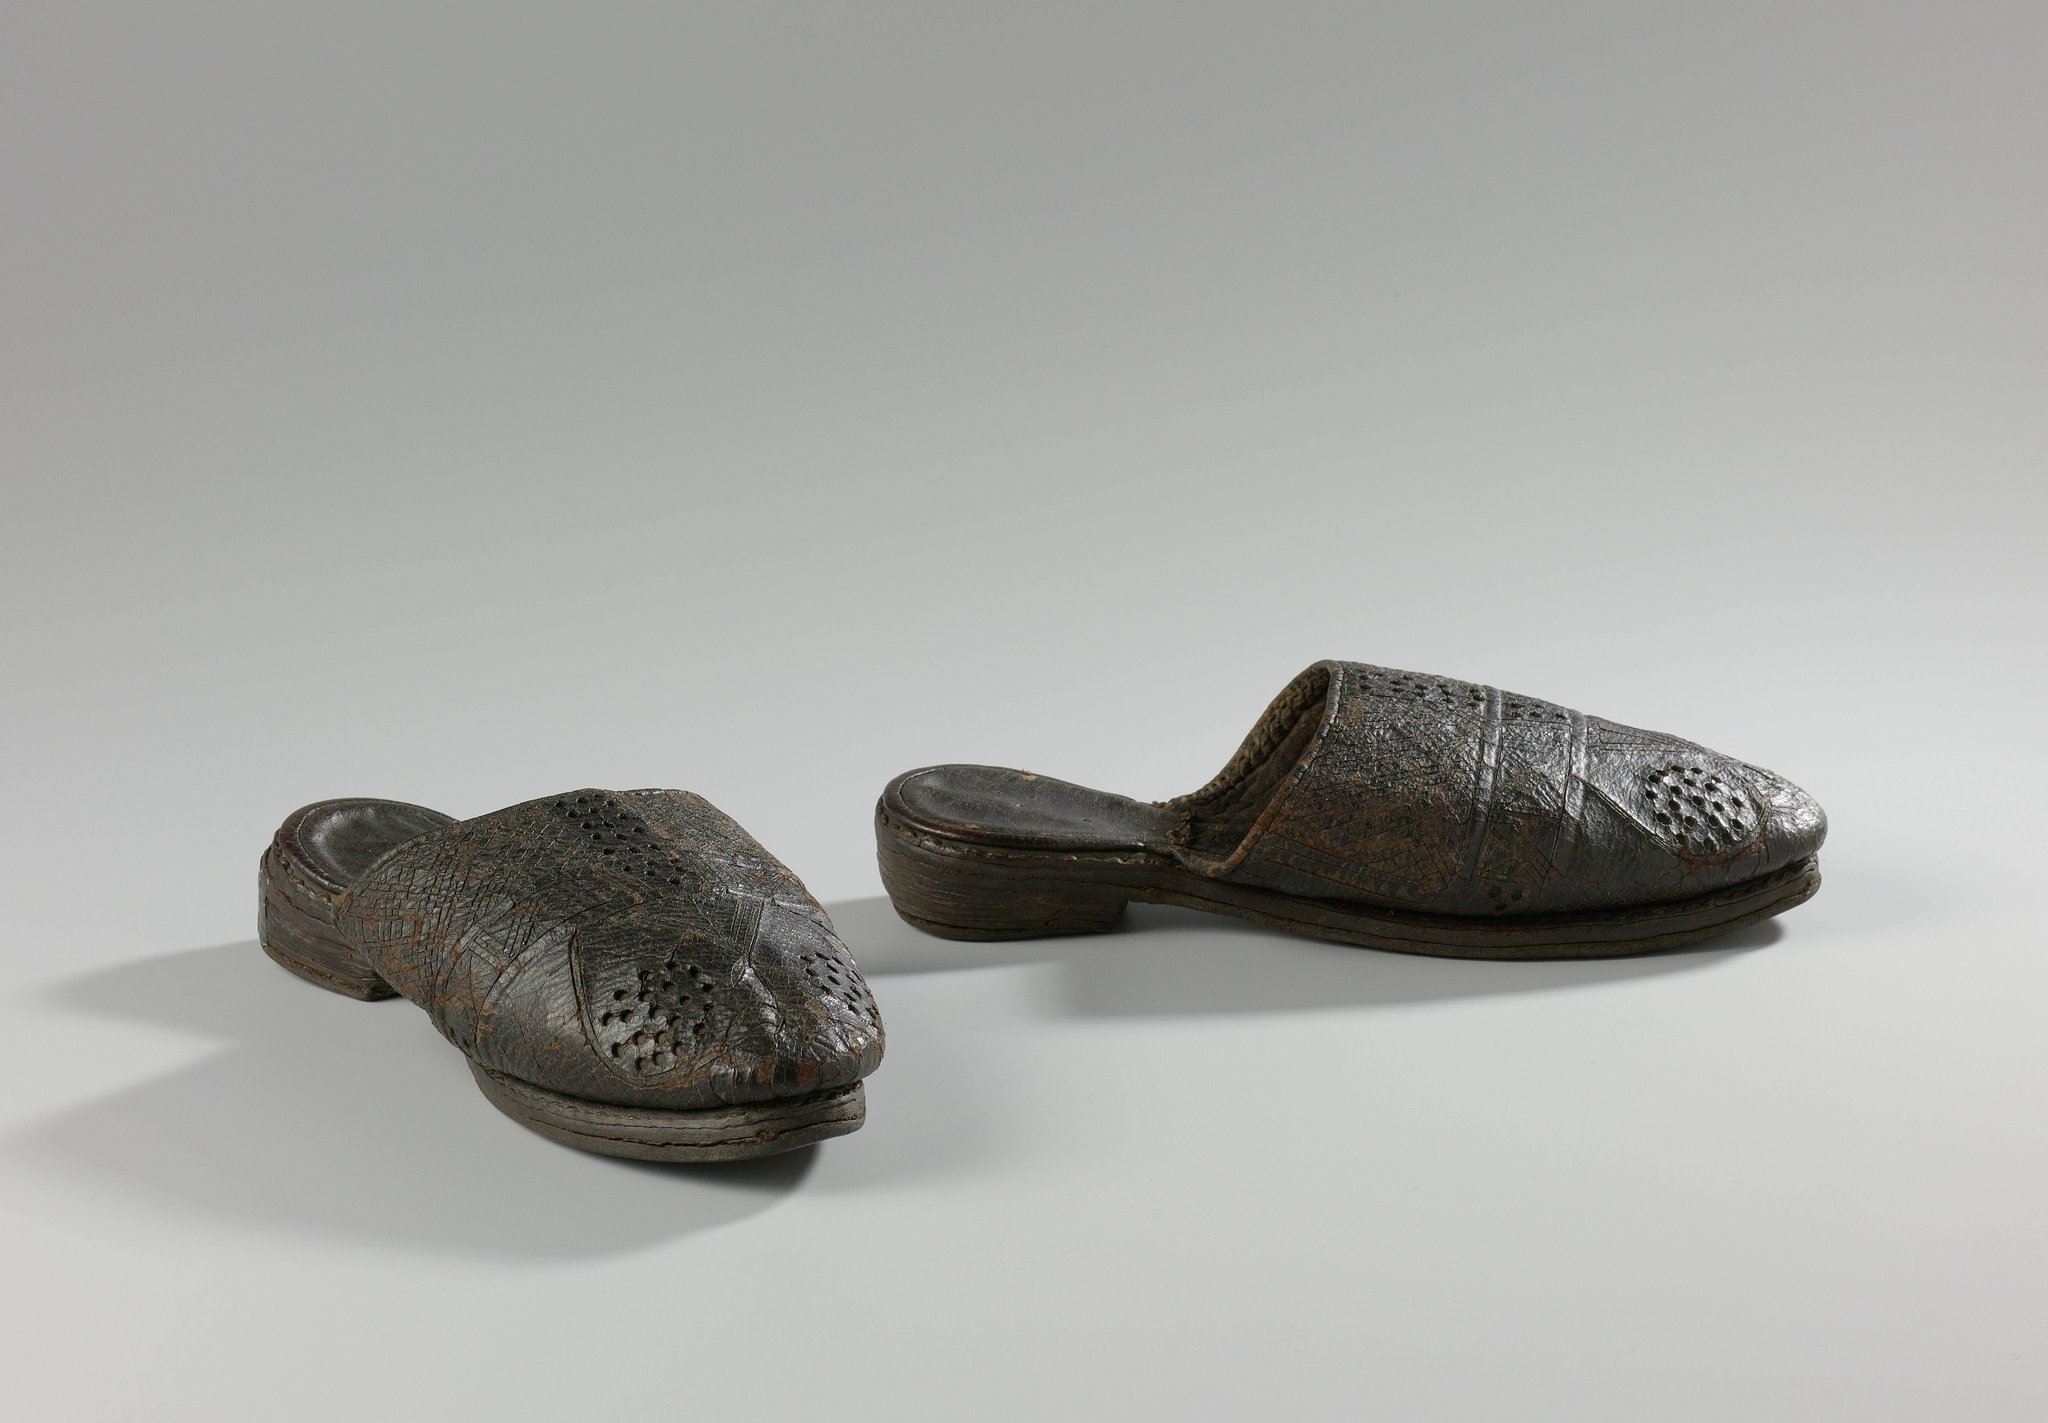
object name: mule shoe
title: Muil van zwart leer met lage hak en ronde neus, hoog voorblad met perforaties en inkervingen in streepdessin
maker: Anonymous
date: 1600-1650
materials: fiber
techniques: perforating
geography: northern netherlands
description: Een paar vrouwenmuilen van zwart leer, links en rechts gelijk. Lage hak ronde neus, vrij smalle, getailleerde zool. Hoog voorblad met perforaties en inkervingen.